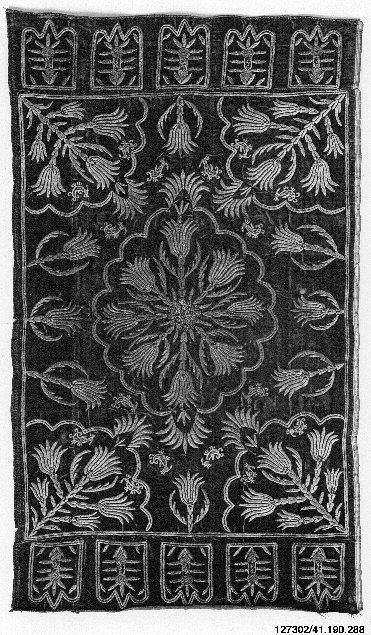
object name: cushion cover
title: Cushion Cover (Yastik)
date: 1767-1800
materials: metal thread, silk, velvet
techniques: embroidery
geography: turkey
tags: flowers